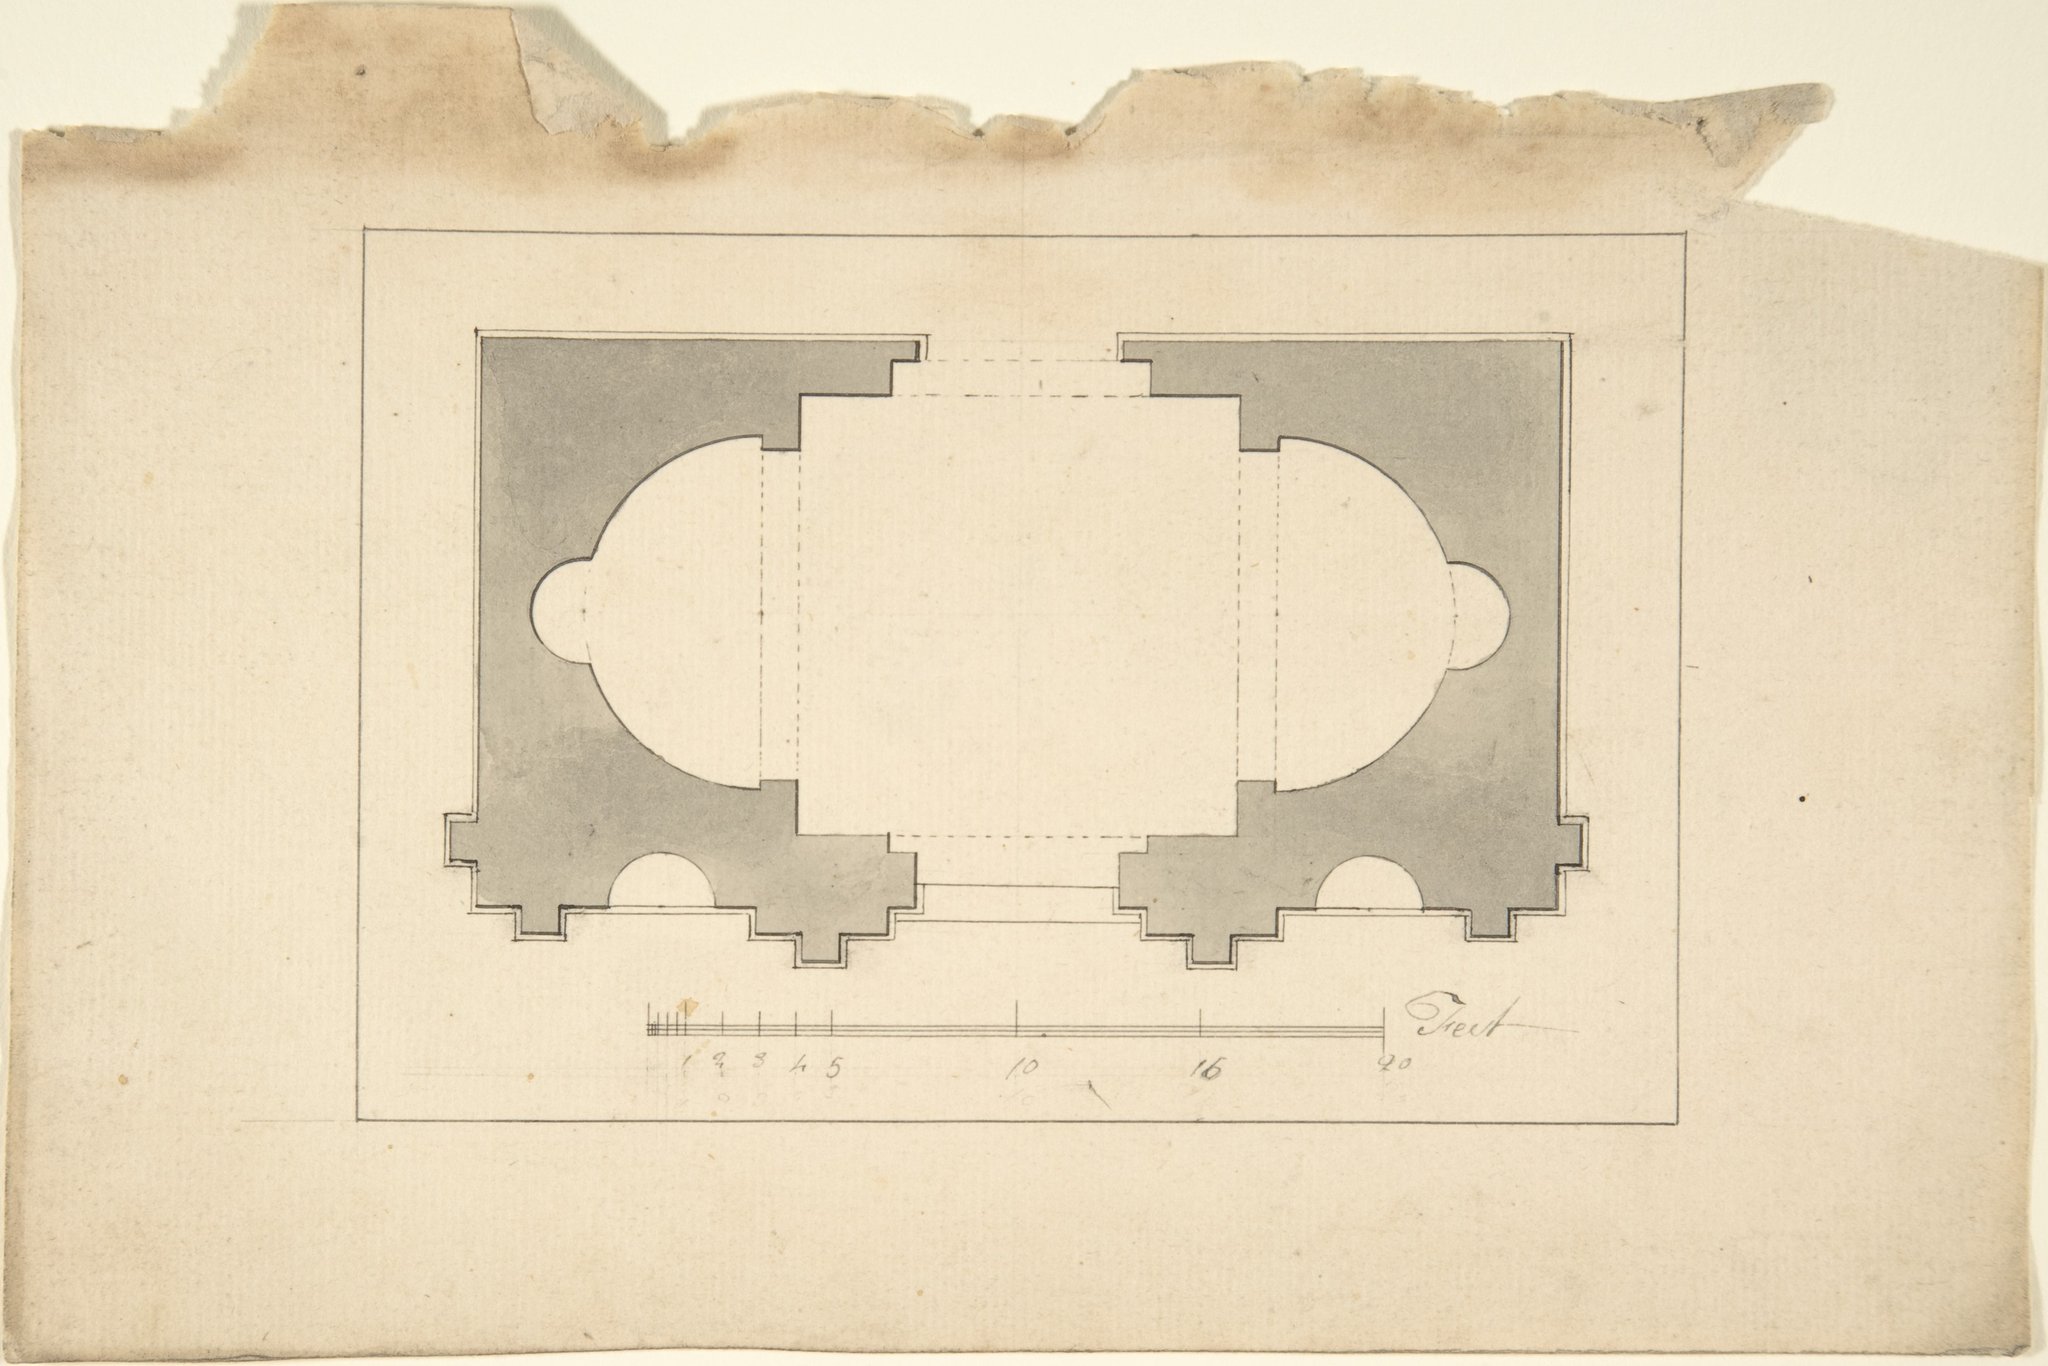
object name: drawing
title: Plan for Garden Pavilion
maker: robert morris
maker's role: artist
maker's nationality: british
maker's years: 1701-1754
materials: ink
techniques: brush, pen, wash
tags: architecture